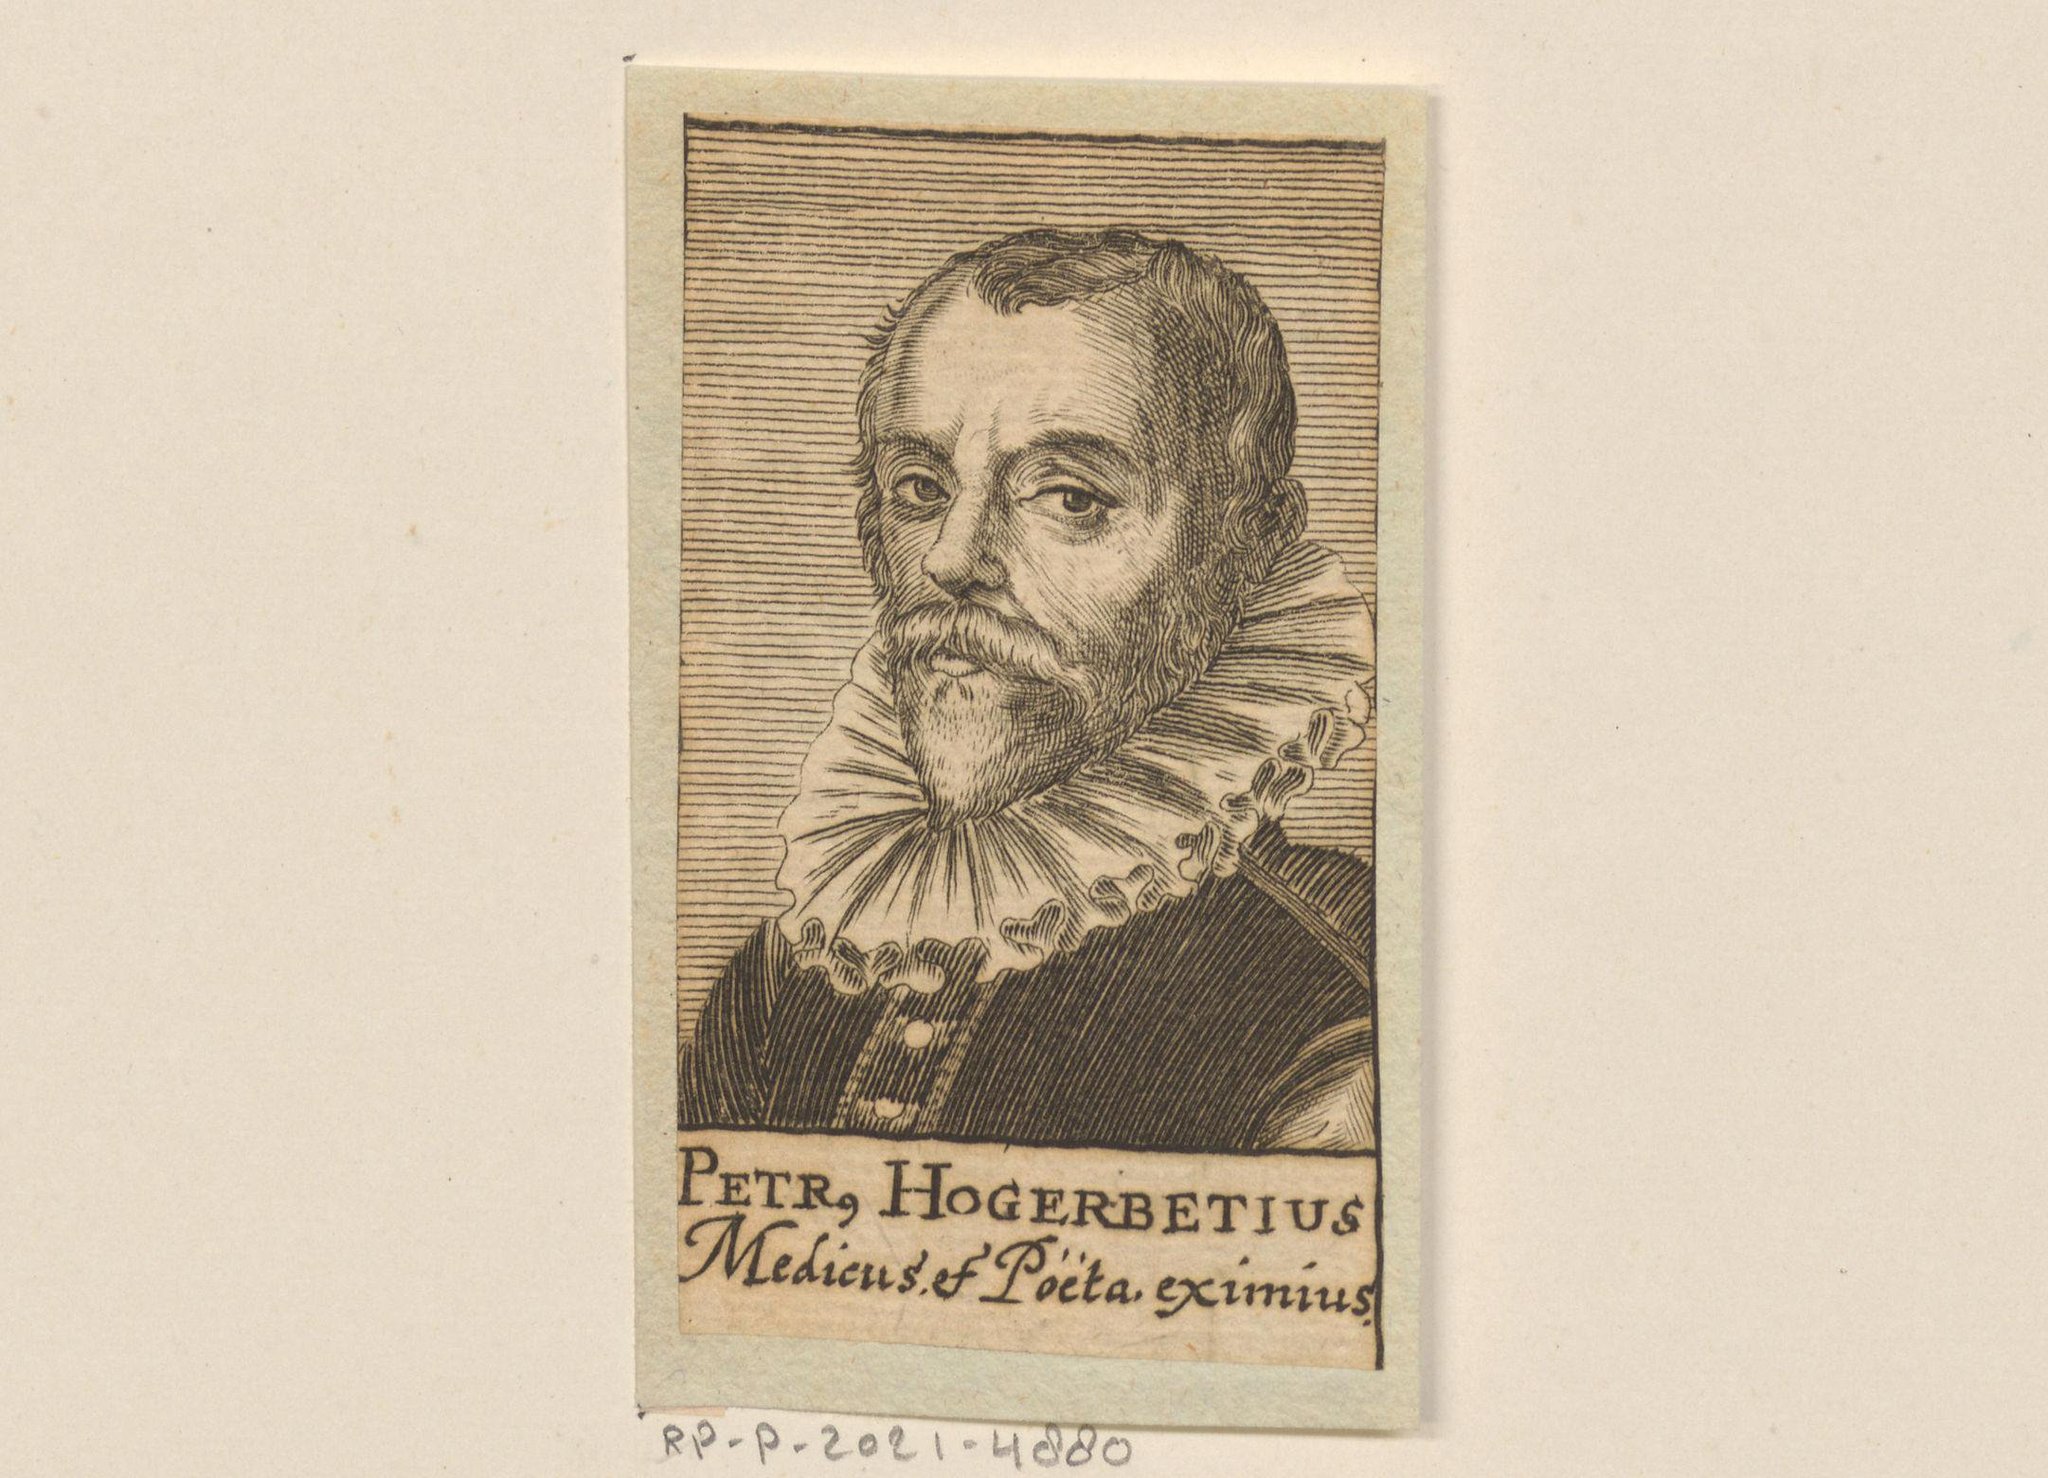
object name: book illustration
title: Portret van Petrus Hogerbeets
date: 1688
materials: paper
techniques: engraving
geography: nuremberg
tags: hoorn (north holland), petrus hogerbeets, historical persons, physician, doctor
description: Prent uit: Freher, Paul. Theatrum virorum eruditione clarorum. Neurenberg: Johann Hoffmann, 1688.